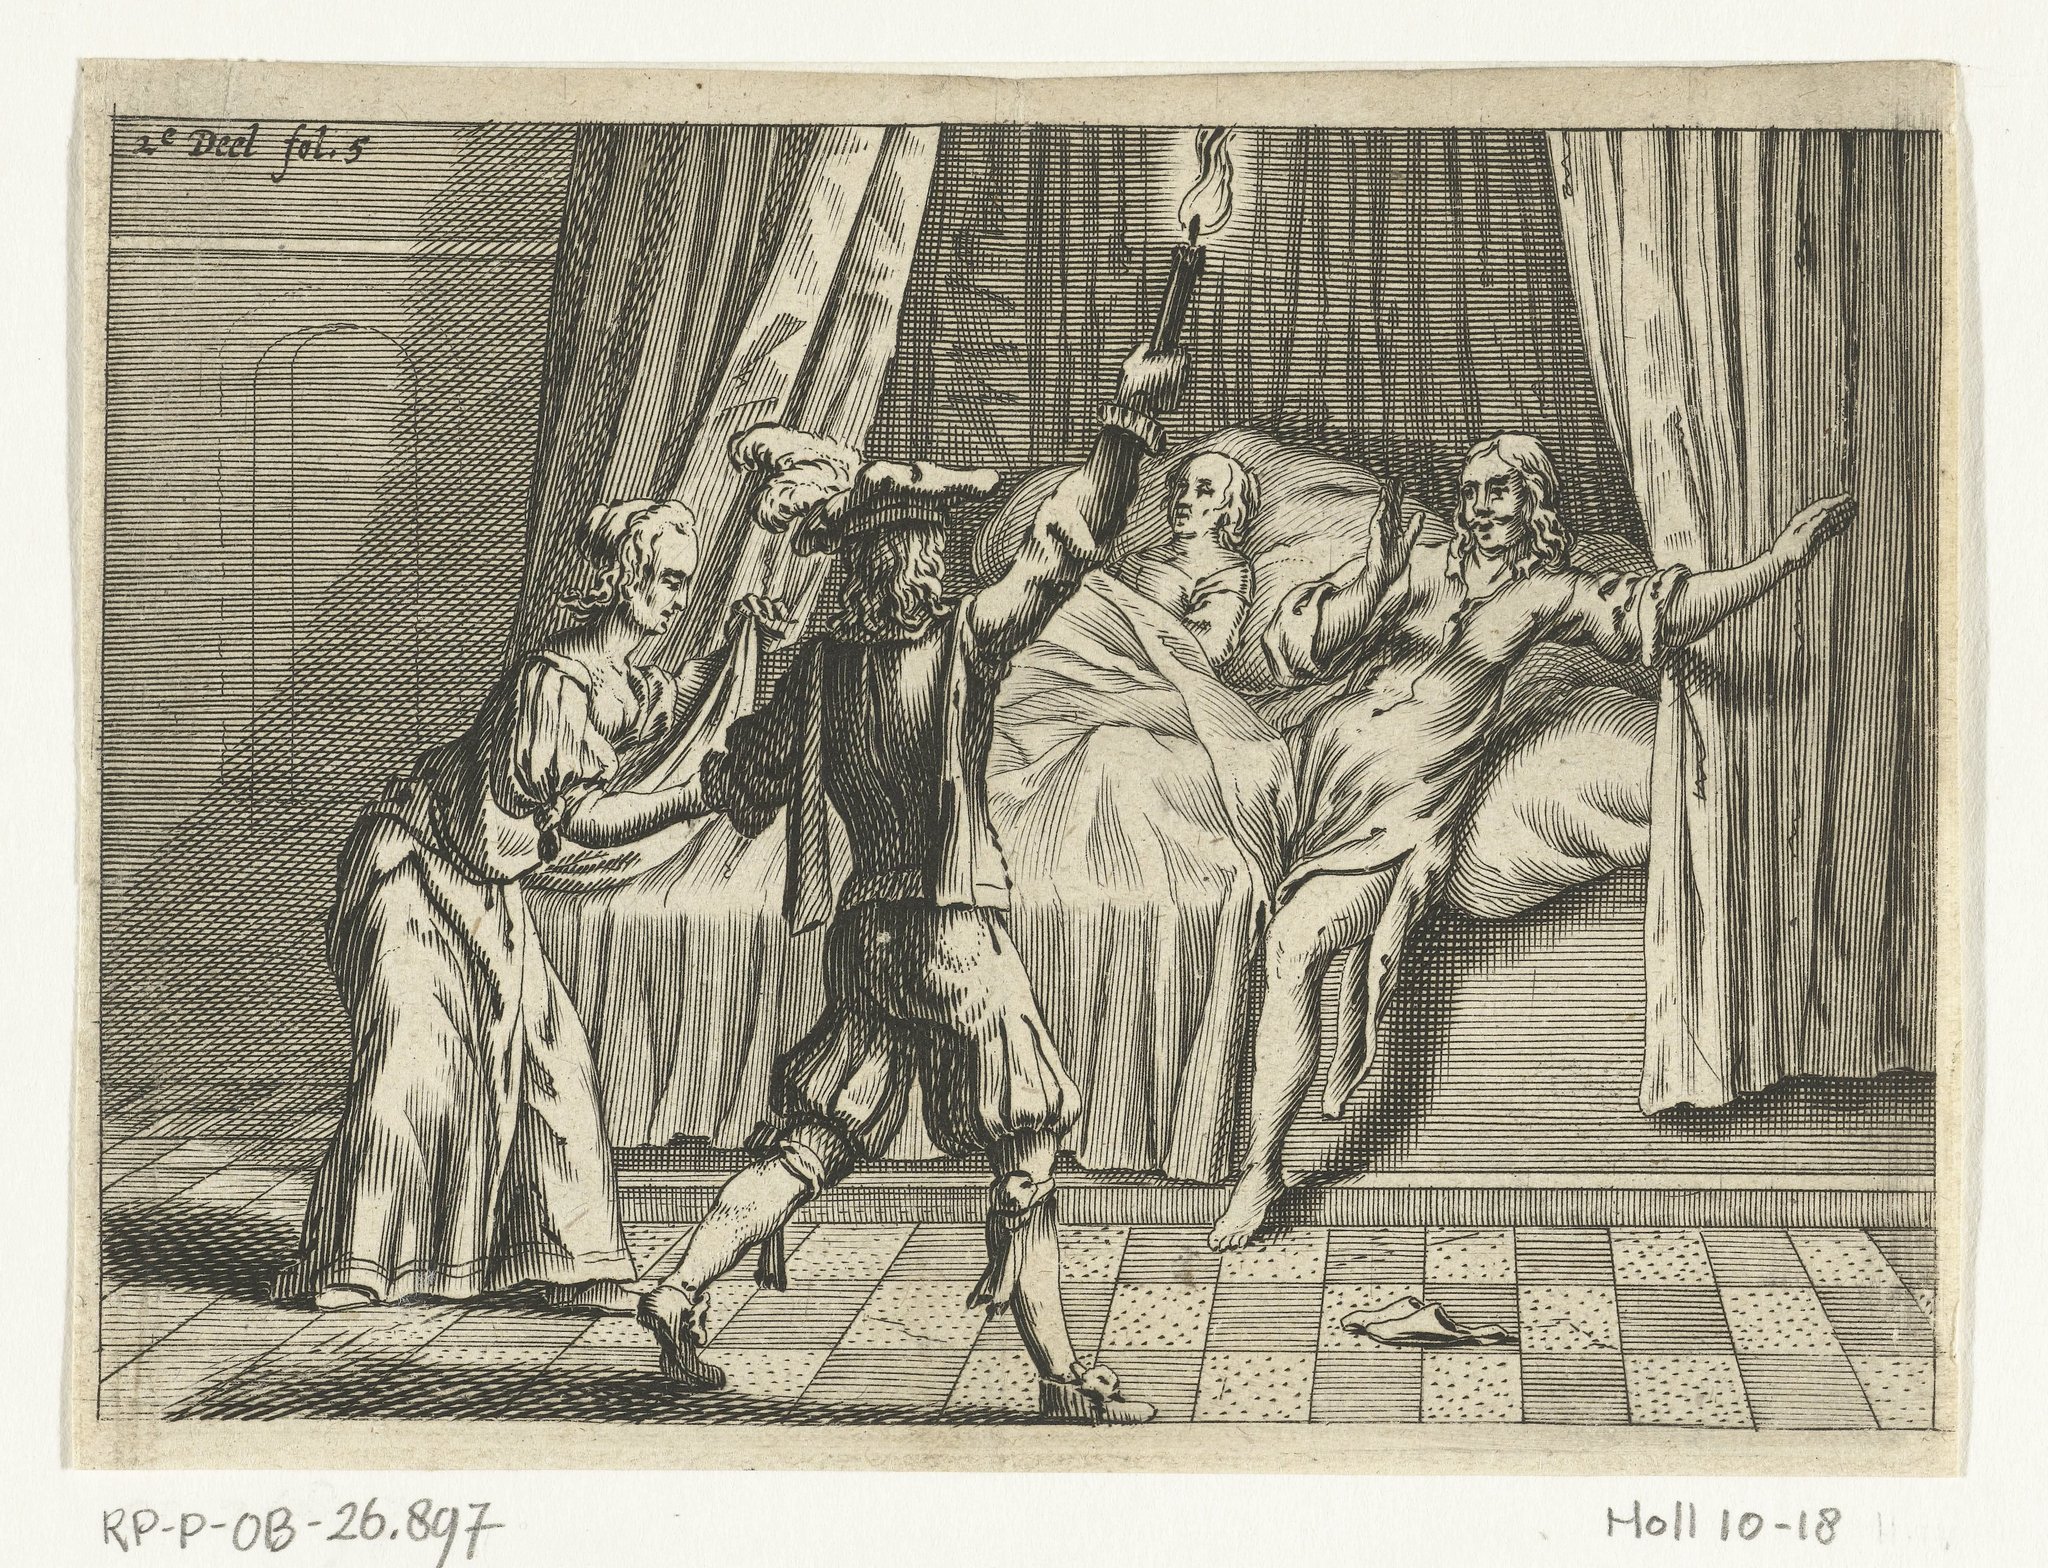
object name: print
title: Gusman d'Alfarache bij bed met dames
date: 1655-1697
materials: paper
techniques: engraving, etching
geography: netherlands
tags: bedroom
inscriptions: collector's mark: Lugt 2228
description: Boekillustratie uit: Mateo Alemán, Het leven van Gusman d'Alfarache, mogelijk Rotterdam, onbekend jaar, deel 2, nr. 5. Mogelijk kopie naar Jan de Bray, vergelijk inv.nr. RP-P-1901-A-22273.